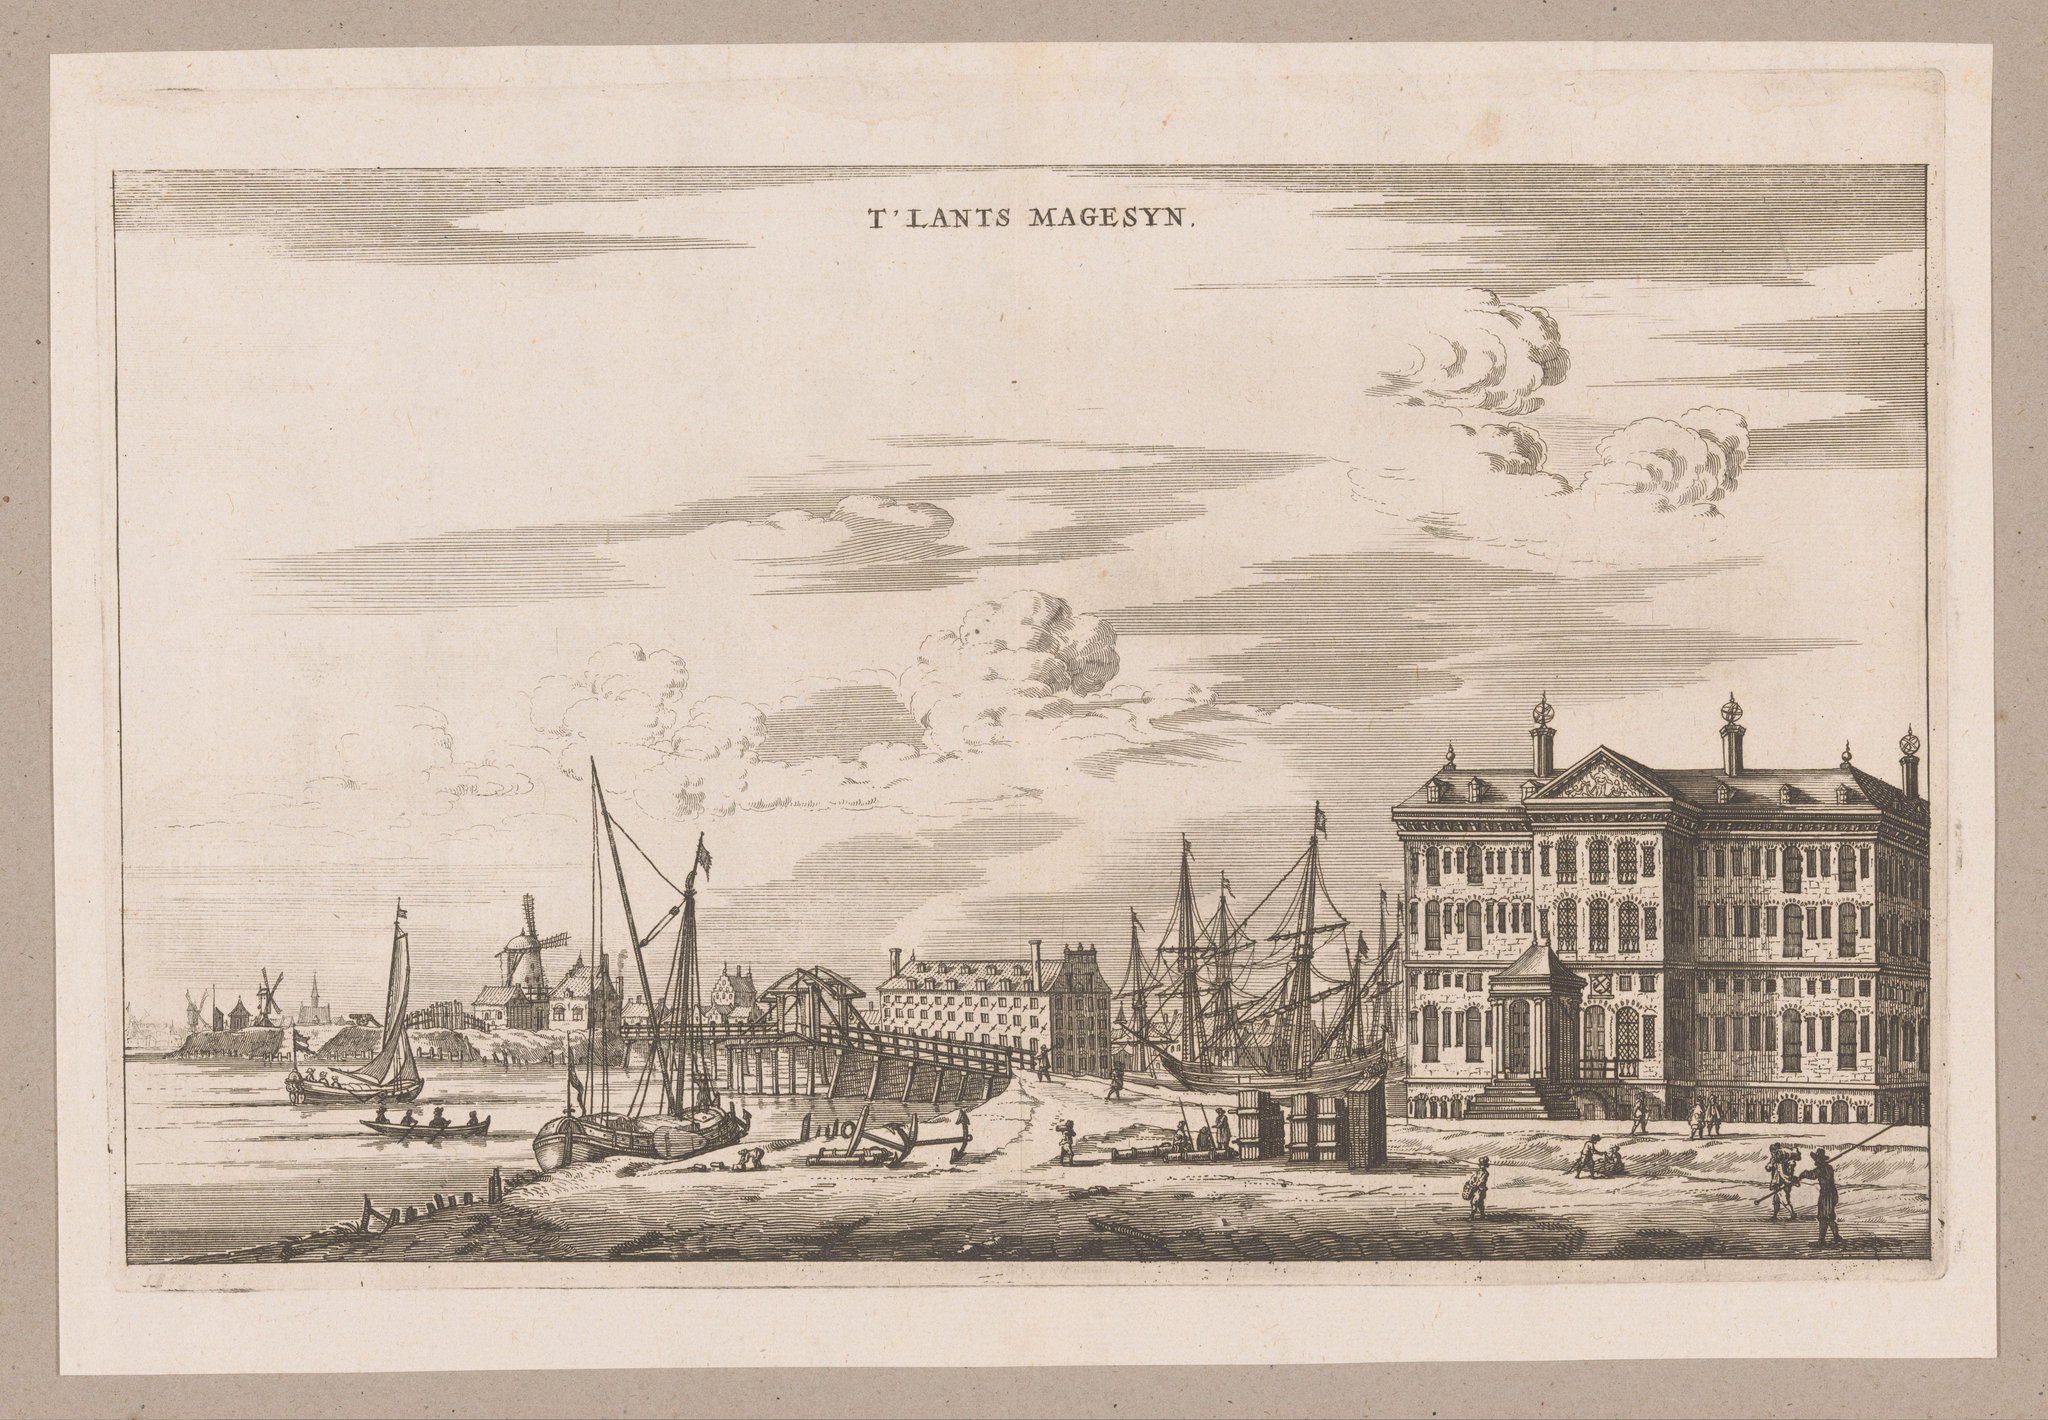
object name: print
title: T'Lants Magesyn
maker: jacob van meurs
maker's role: draughtsman, print maker, publisher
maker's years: 1619-1680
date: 1663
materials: paper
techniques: etching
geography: amsterdam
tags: pier, quay, wharf, civic architecture; edifices; dwellings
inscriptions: watermark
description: Prent verschenen in: Dapper, Olfert. Historische beschryving der stadt Amsterdam: waer in de voornaemste geschiedenissen (na een kort verhael van gansch Hollant en d'omleggende dorpen (…). Amsterdam: Jacob van Meurs, 1663.